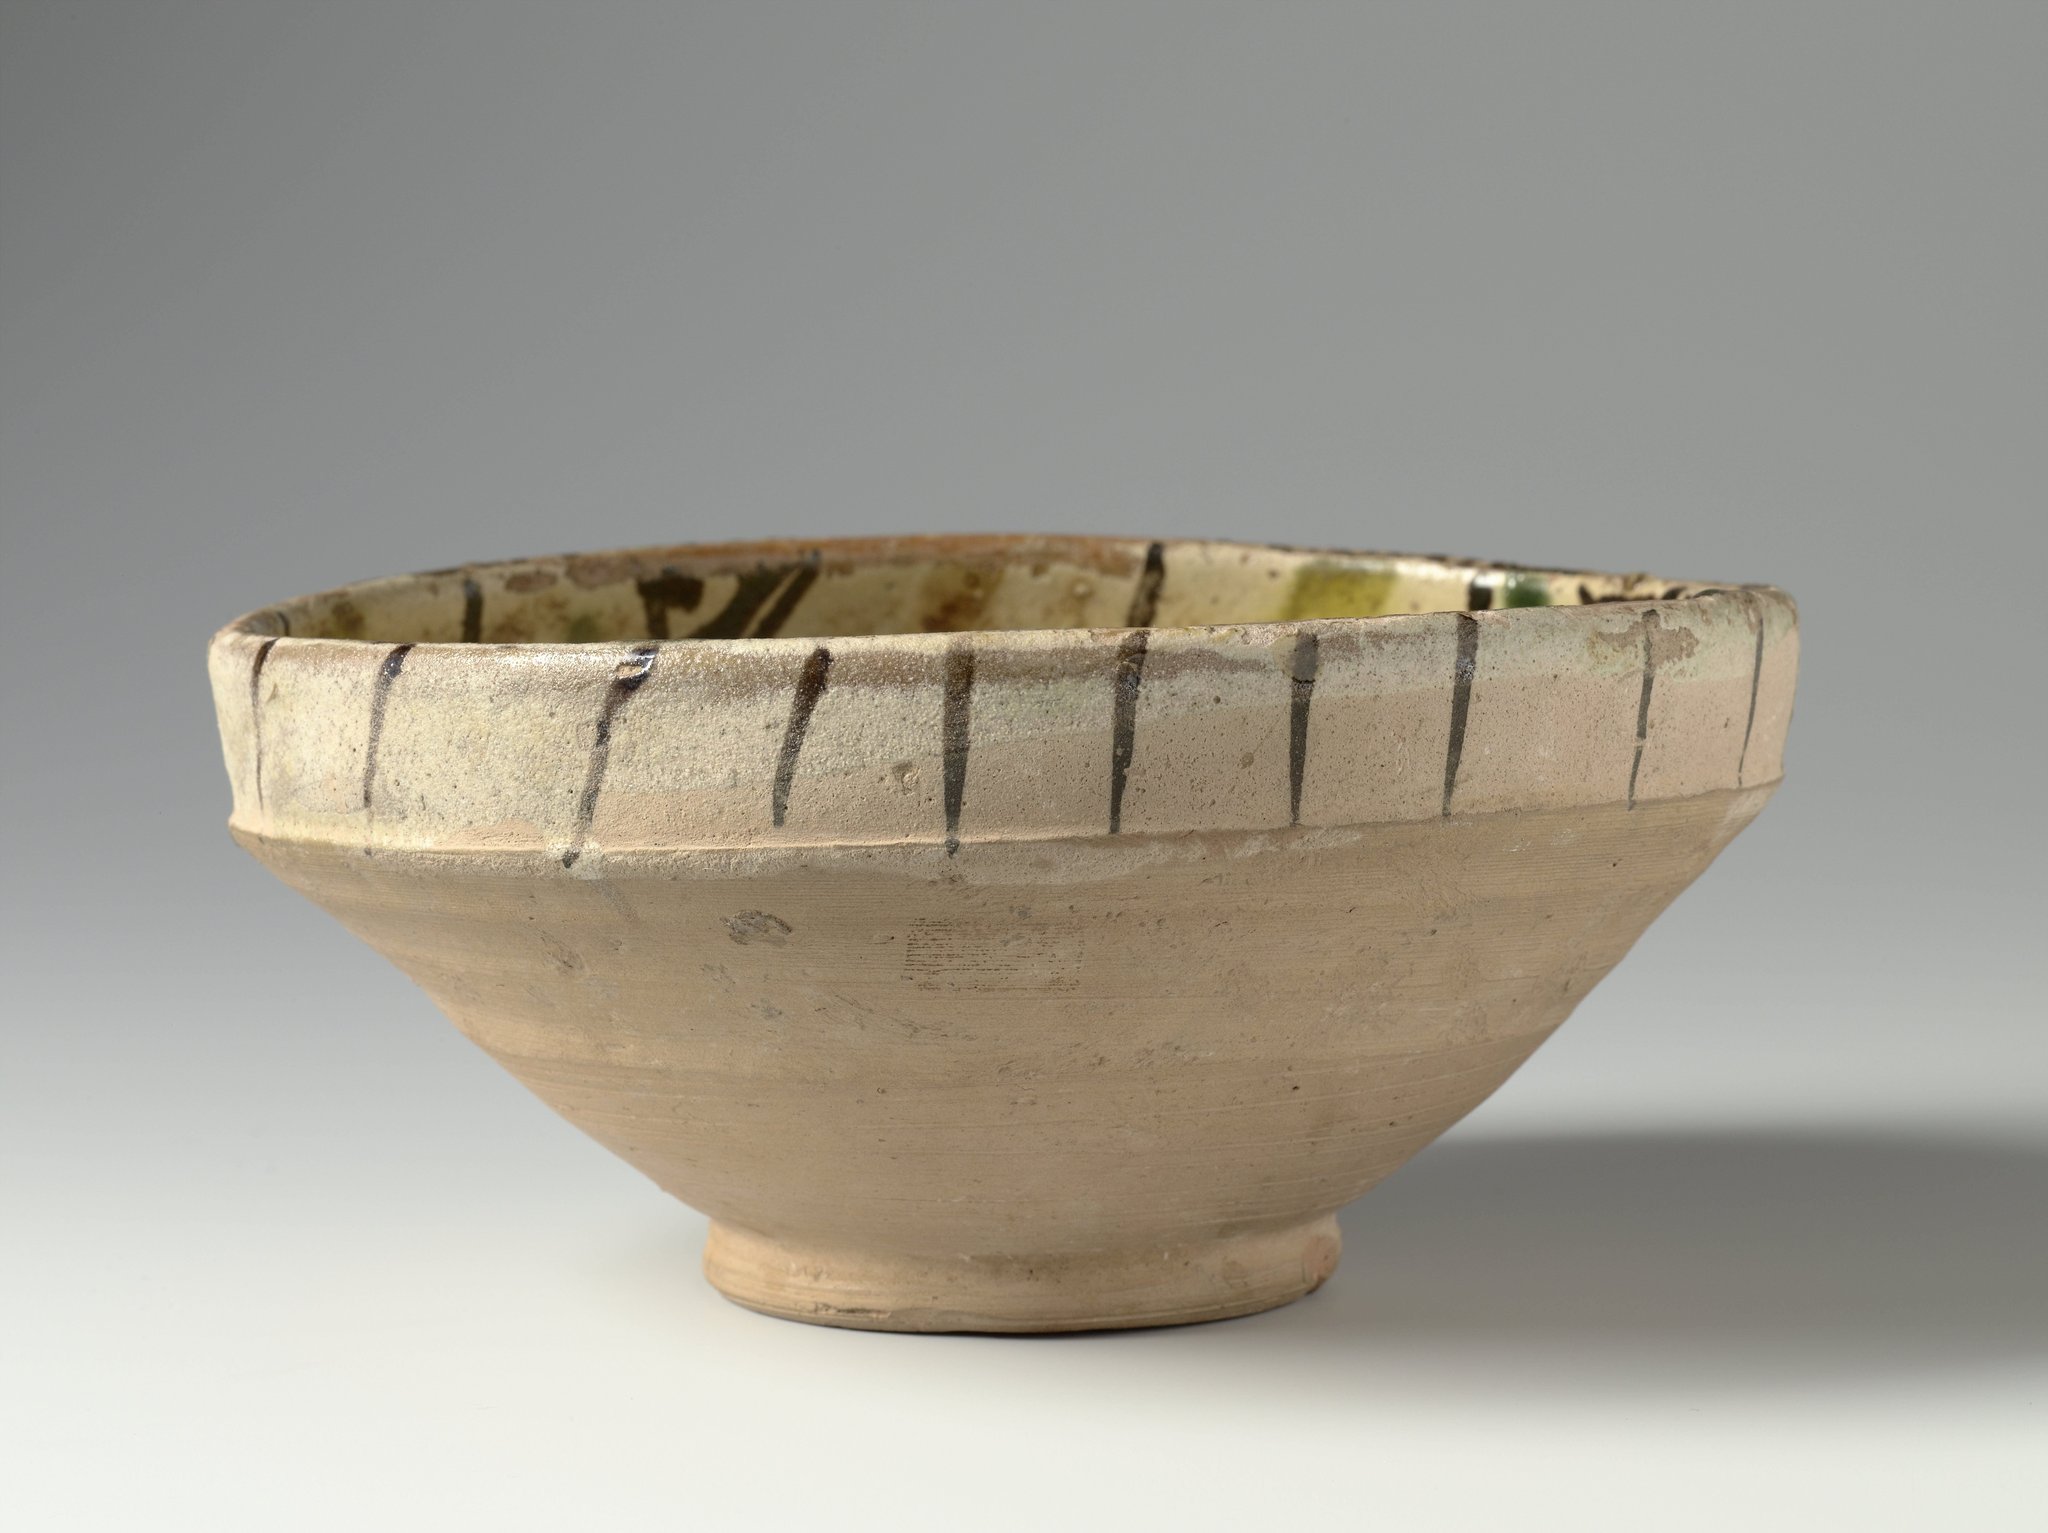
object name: bowl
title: Bowl with with panels and lines in brown and green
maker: Anonymous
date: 900-1099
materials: earthenware, glaze, paint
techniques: firing, turning, vitrification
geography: nishapur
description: Kom van aardewerk gedecoreerd in bruin-zwarte slib en drie loodglazuren (geel, groen en oranje-bruin) met vakken en lijnen op een engobe van beige slib.